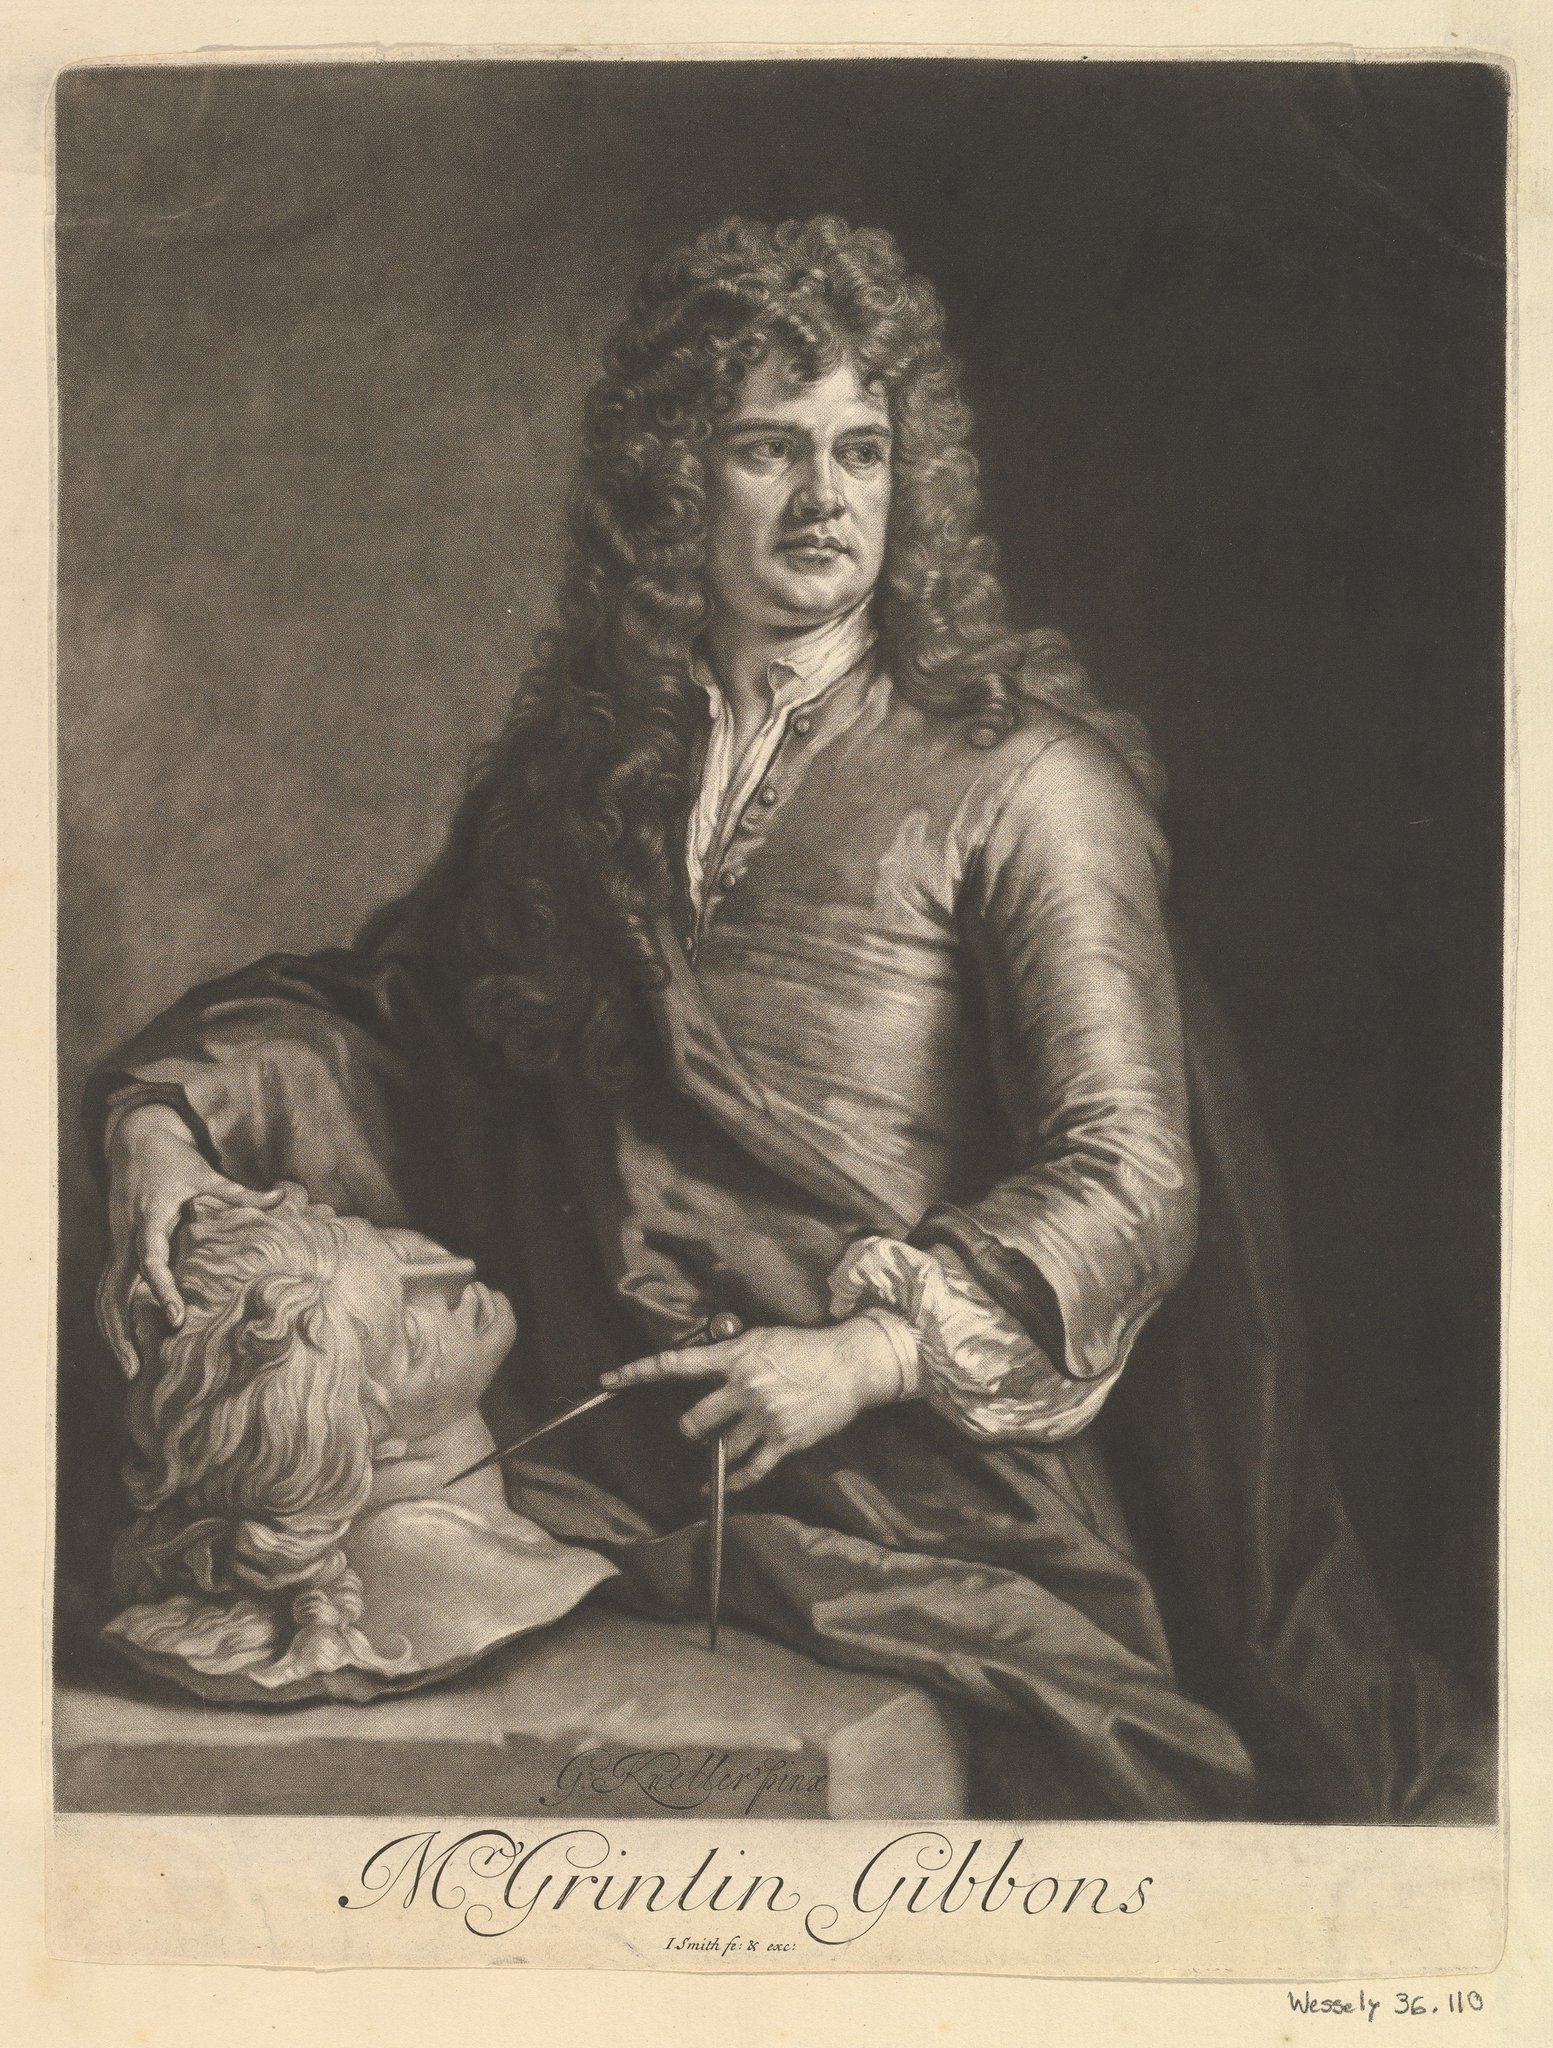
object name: print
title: Grinling Gibbons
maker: sir godfrey kneller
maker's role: artist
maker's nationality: german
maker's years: 1646-1723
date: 1690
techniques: mezzotint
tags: sculpture,heads,men,portraits,artists,compass